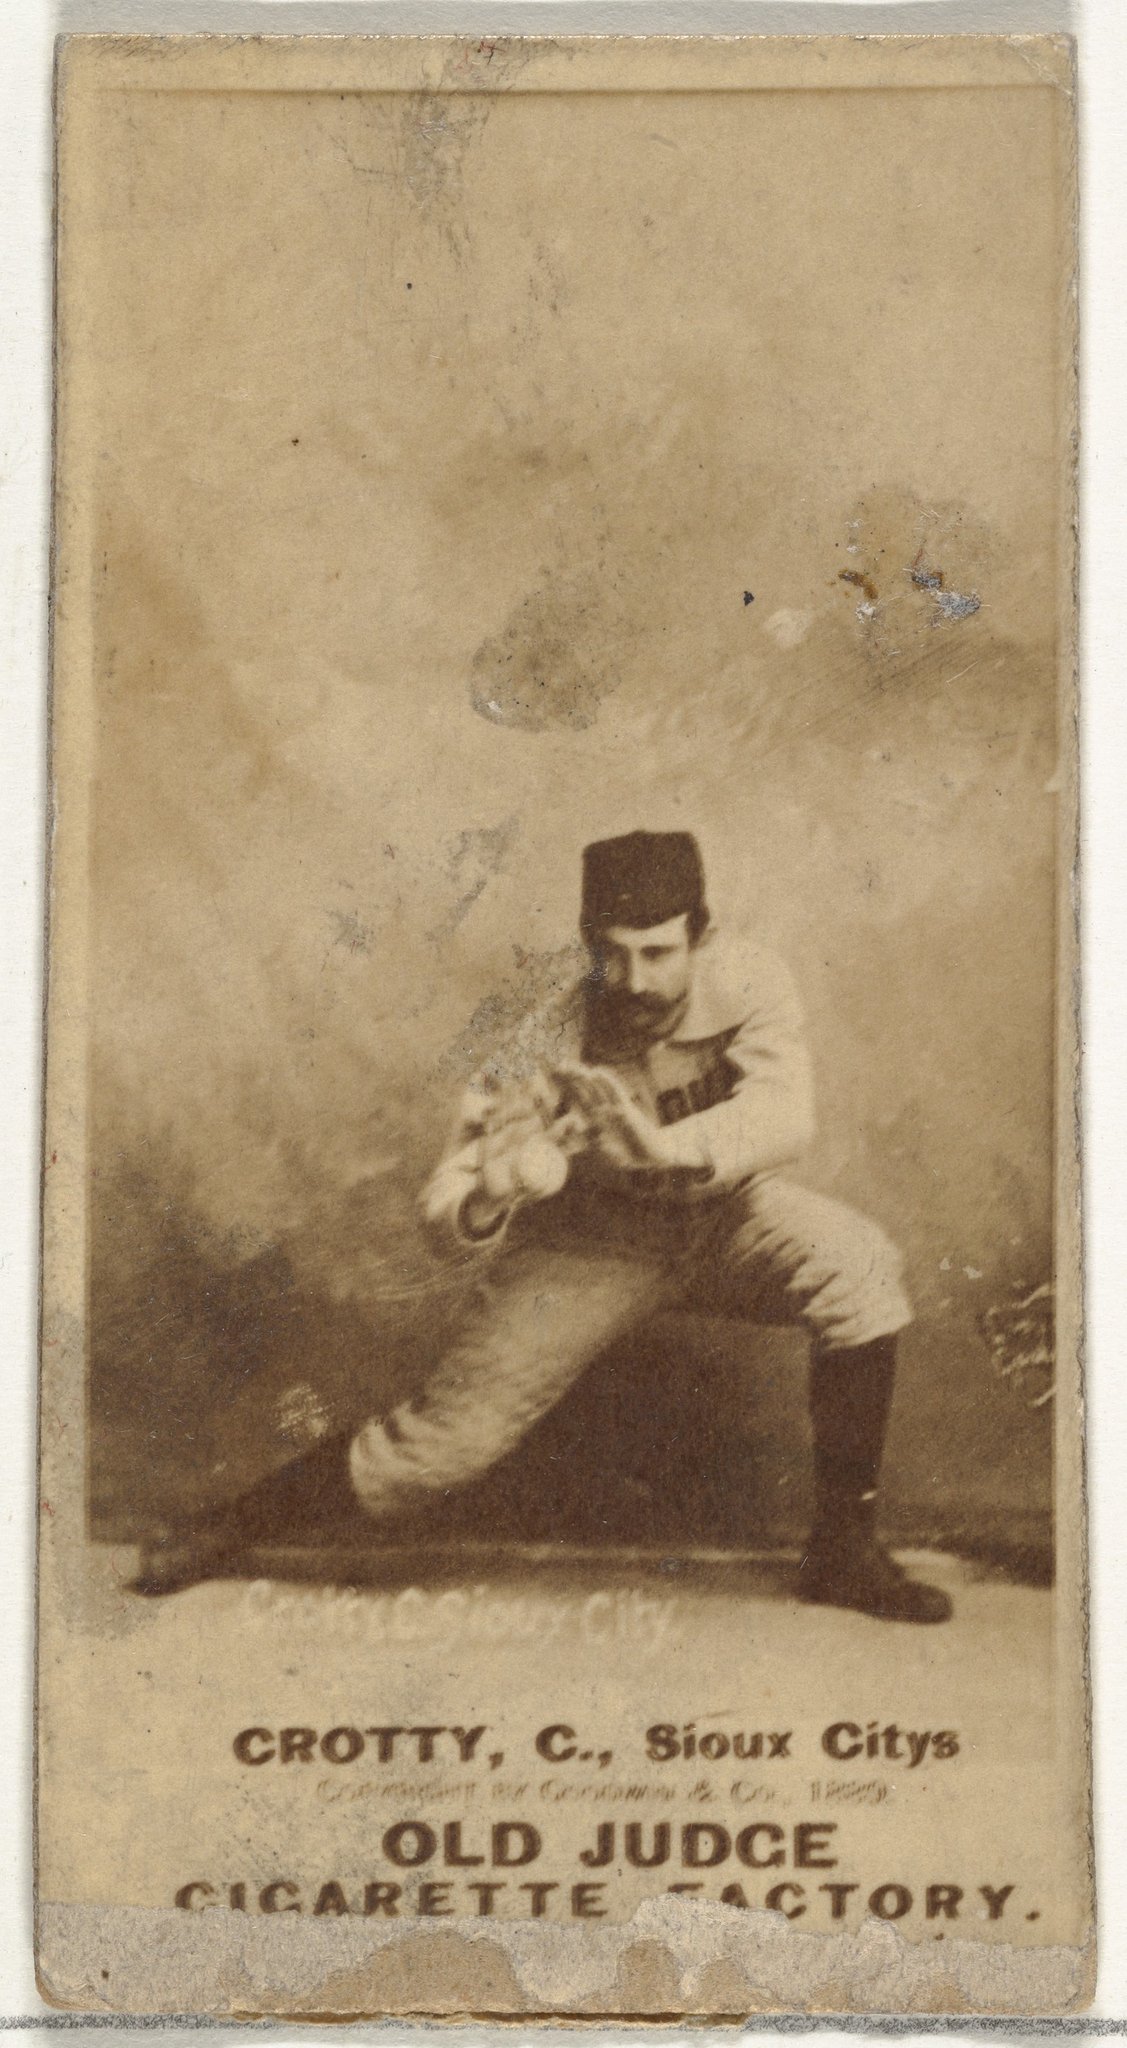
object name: baseball card, photograph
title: Joseph P. "Joe" Crotty, Catcher, Sioux City Corn Huskers, from the Old Judge series (N172) for Old Judge Cigarettes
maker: goodwin & company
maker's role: publisher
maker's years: 1850-1950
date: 1889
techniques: albumen silver print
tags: men,portraits,baseball,athletes